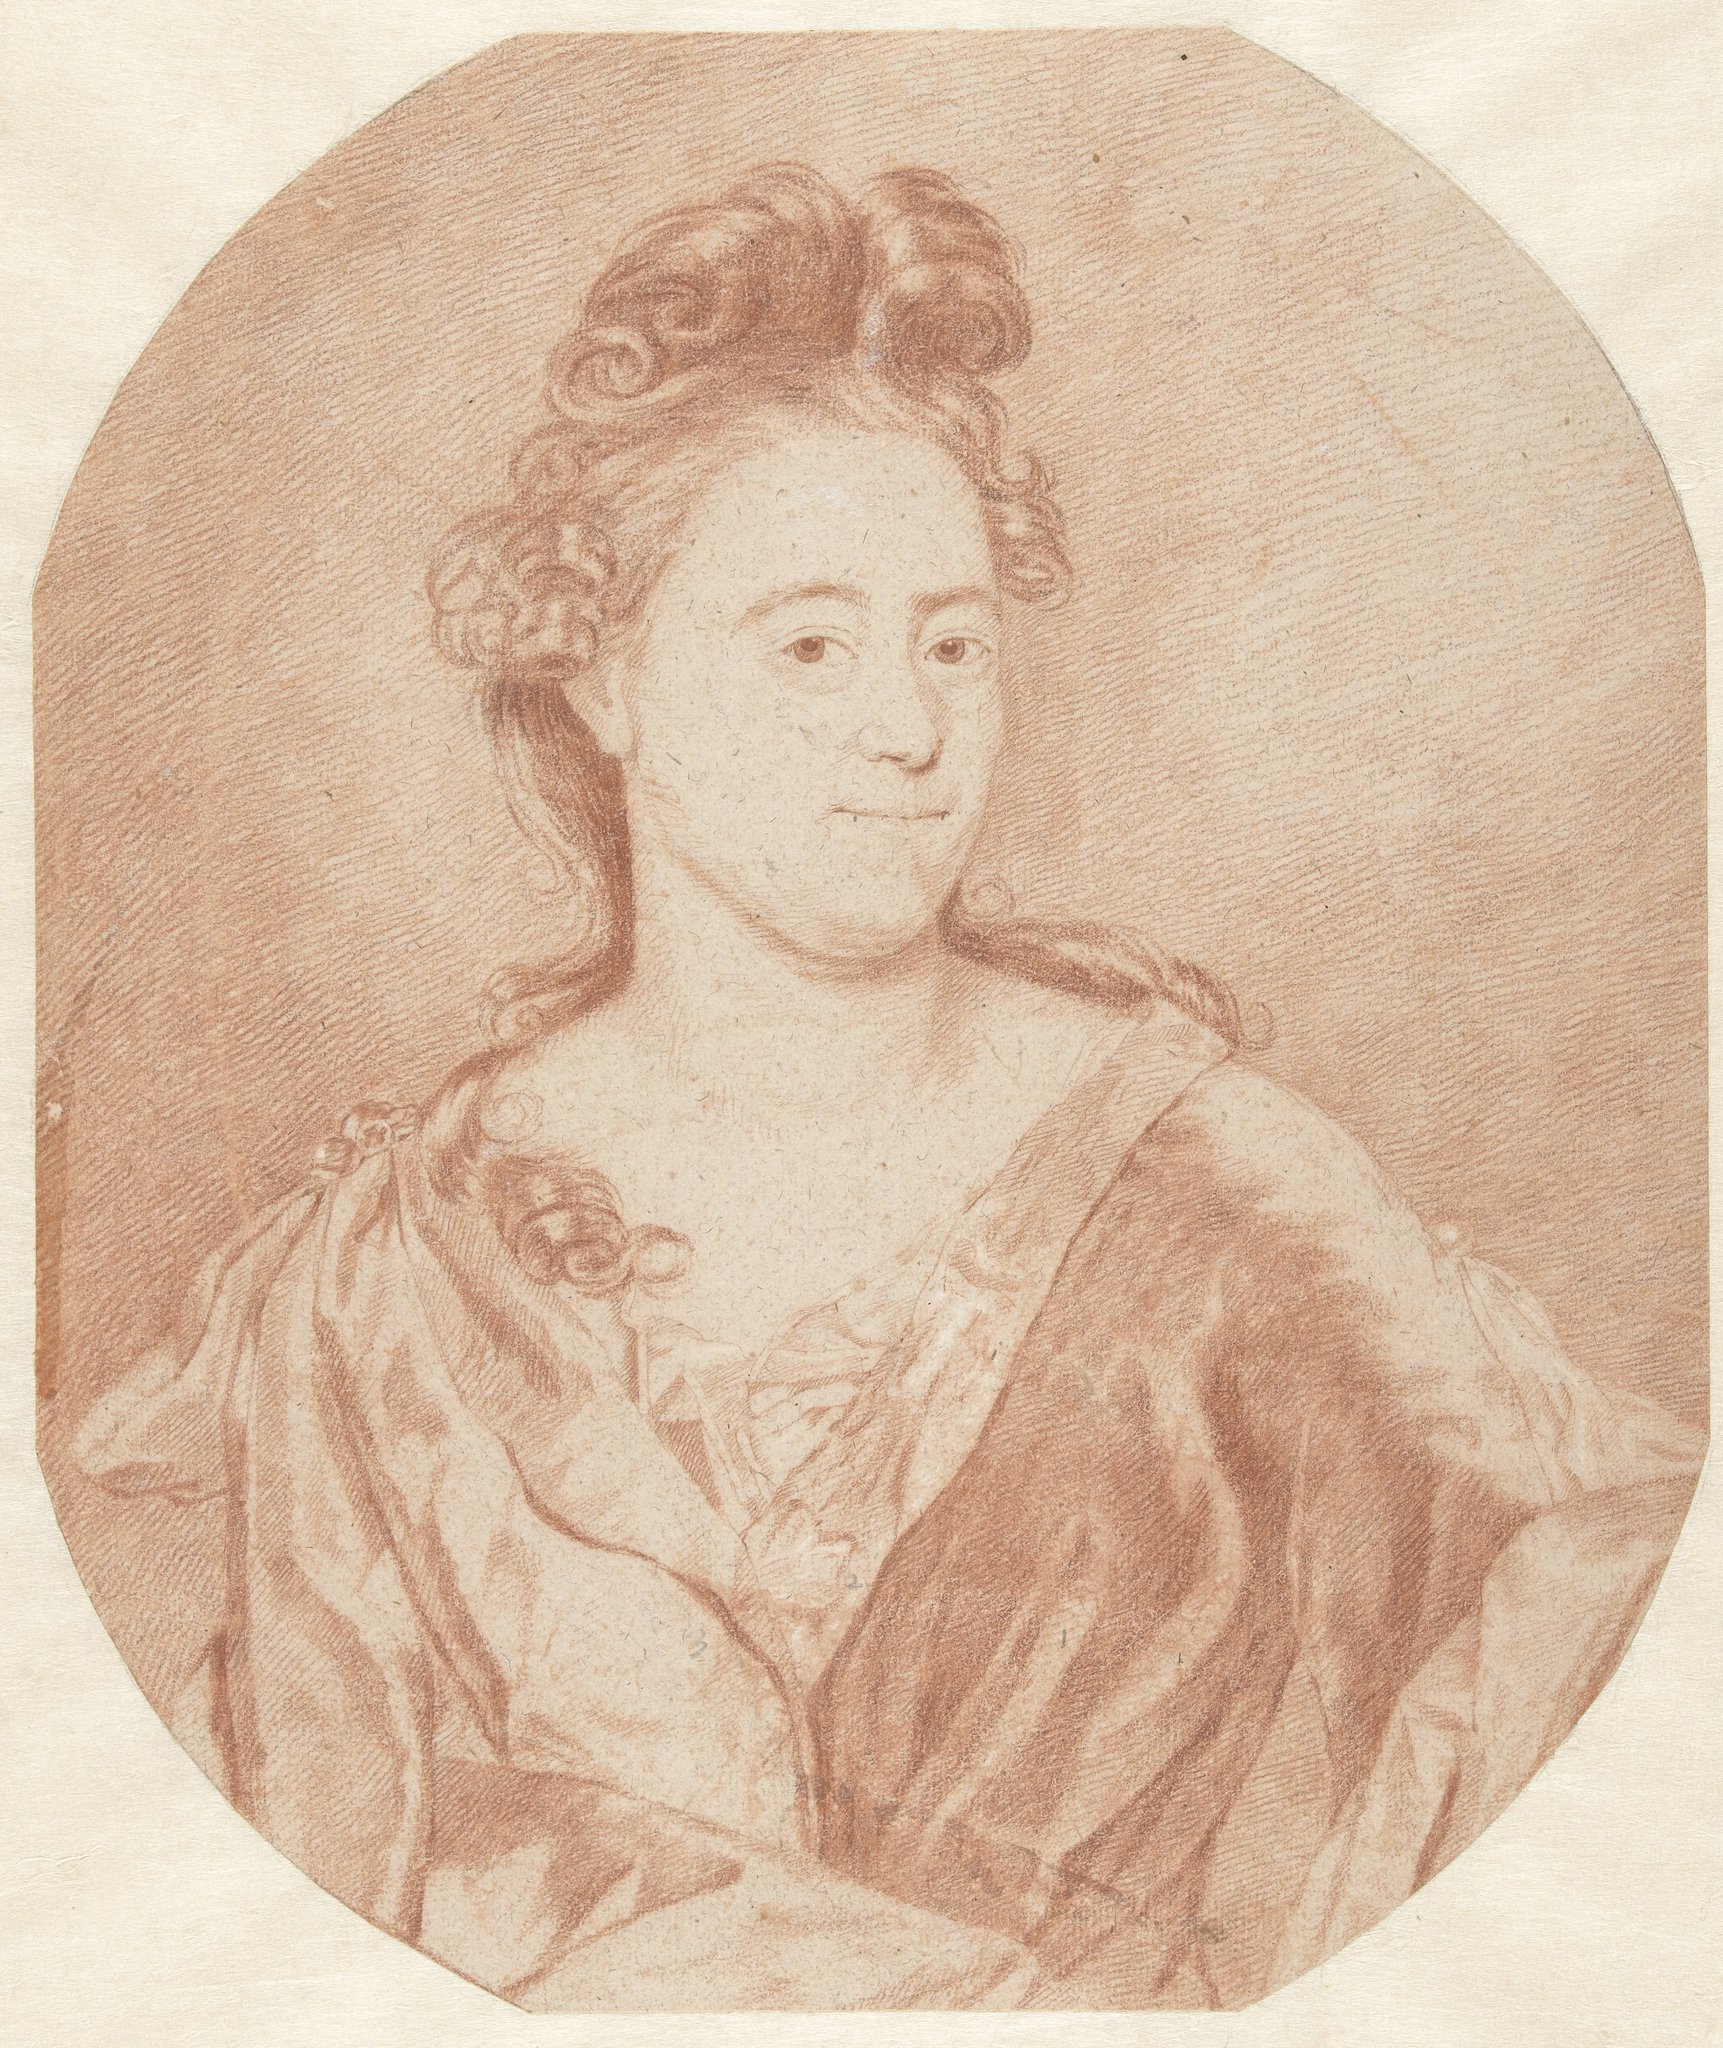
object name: drawing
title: Portret van een onbekende vrouw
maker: godfried schalcken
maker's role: draughtsman, painter, print maker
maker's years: 1643-1706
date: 1653-1706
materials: chalk, paper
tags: anonymous historical person portrayed alone, female sex; woman